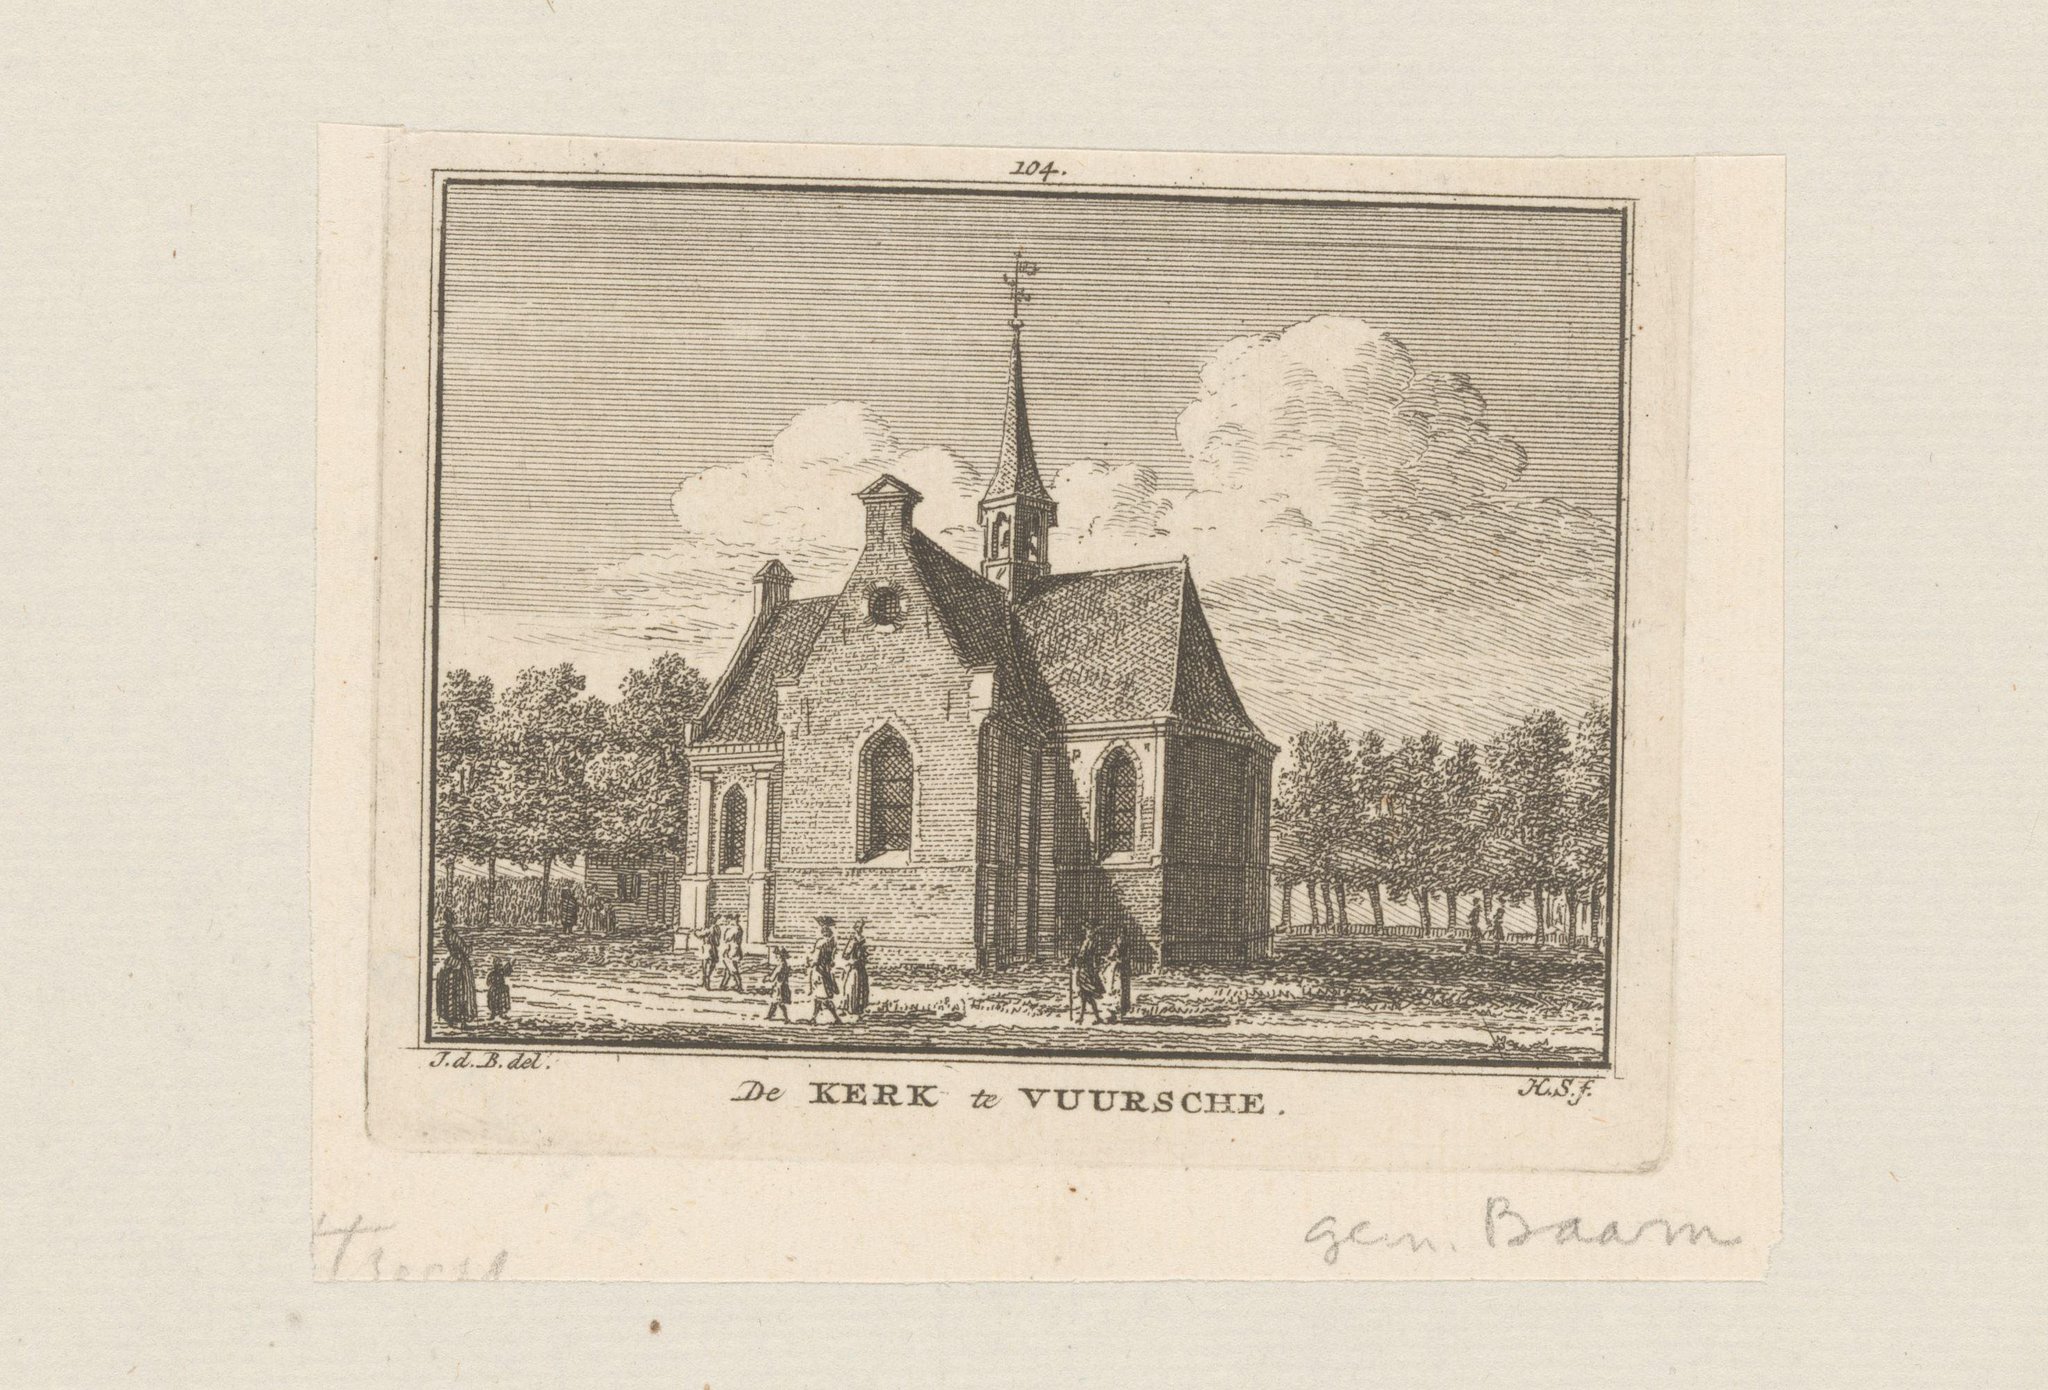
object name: print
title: Gezicht op de kerk van Vuursche, Baarn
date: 1745-1774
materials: paper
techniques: engraving, etching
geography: amsterdam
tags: church (exterior)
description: Prent uit: Spilman, Hendrik. Het verheerlykt Nederland, of kabinet van hedendaagsche gezigten. 9 dln. Amsterdam: Isaac Tirion, 1745-1774.